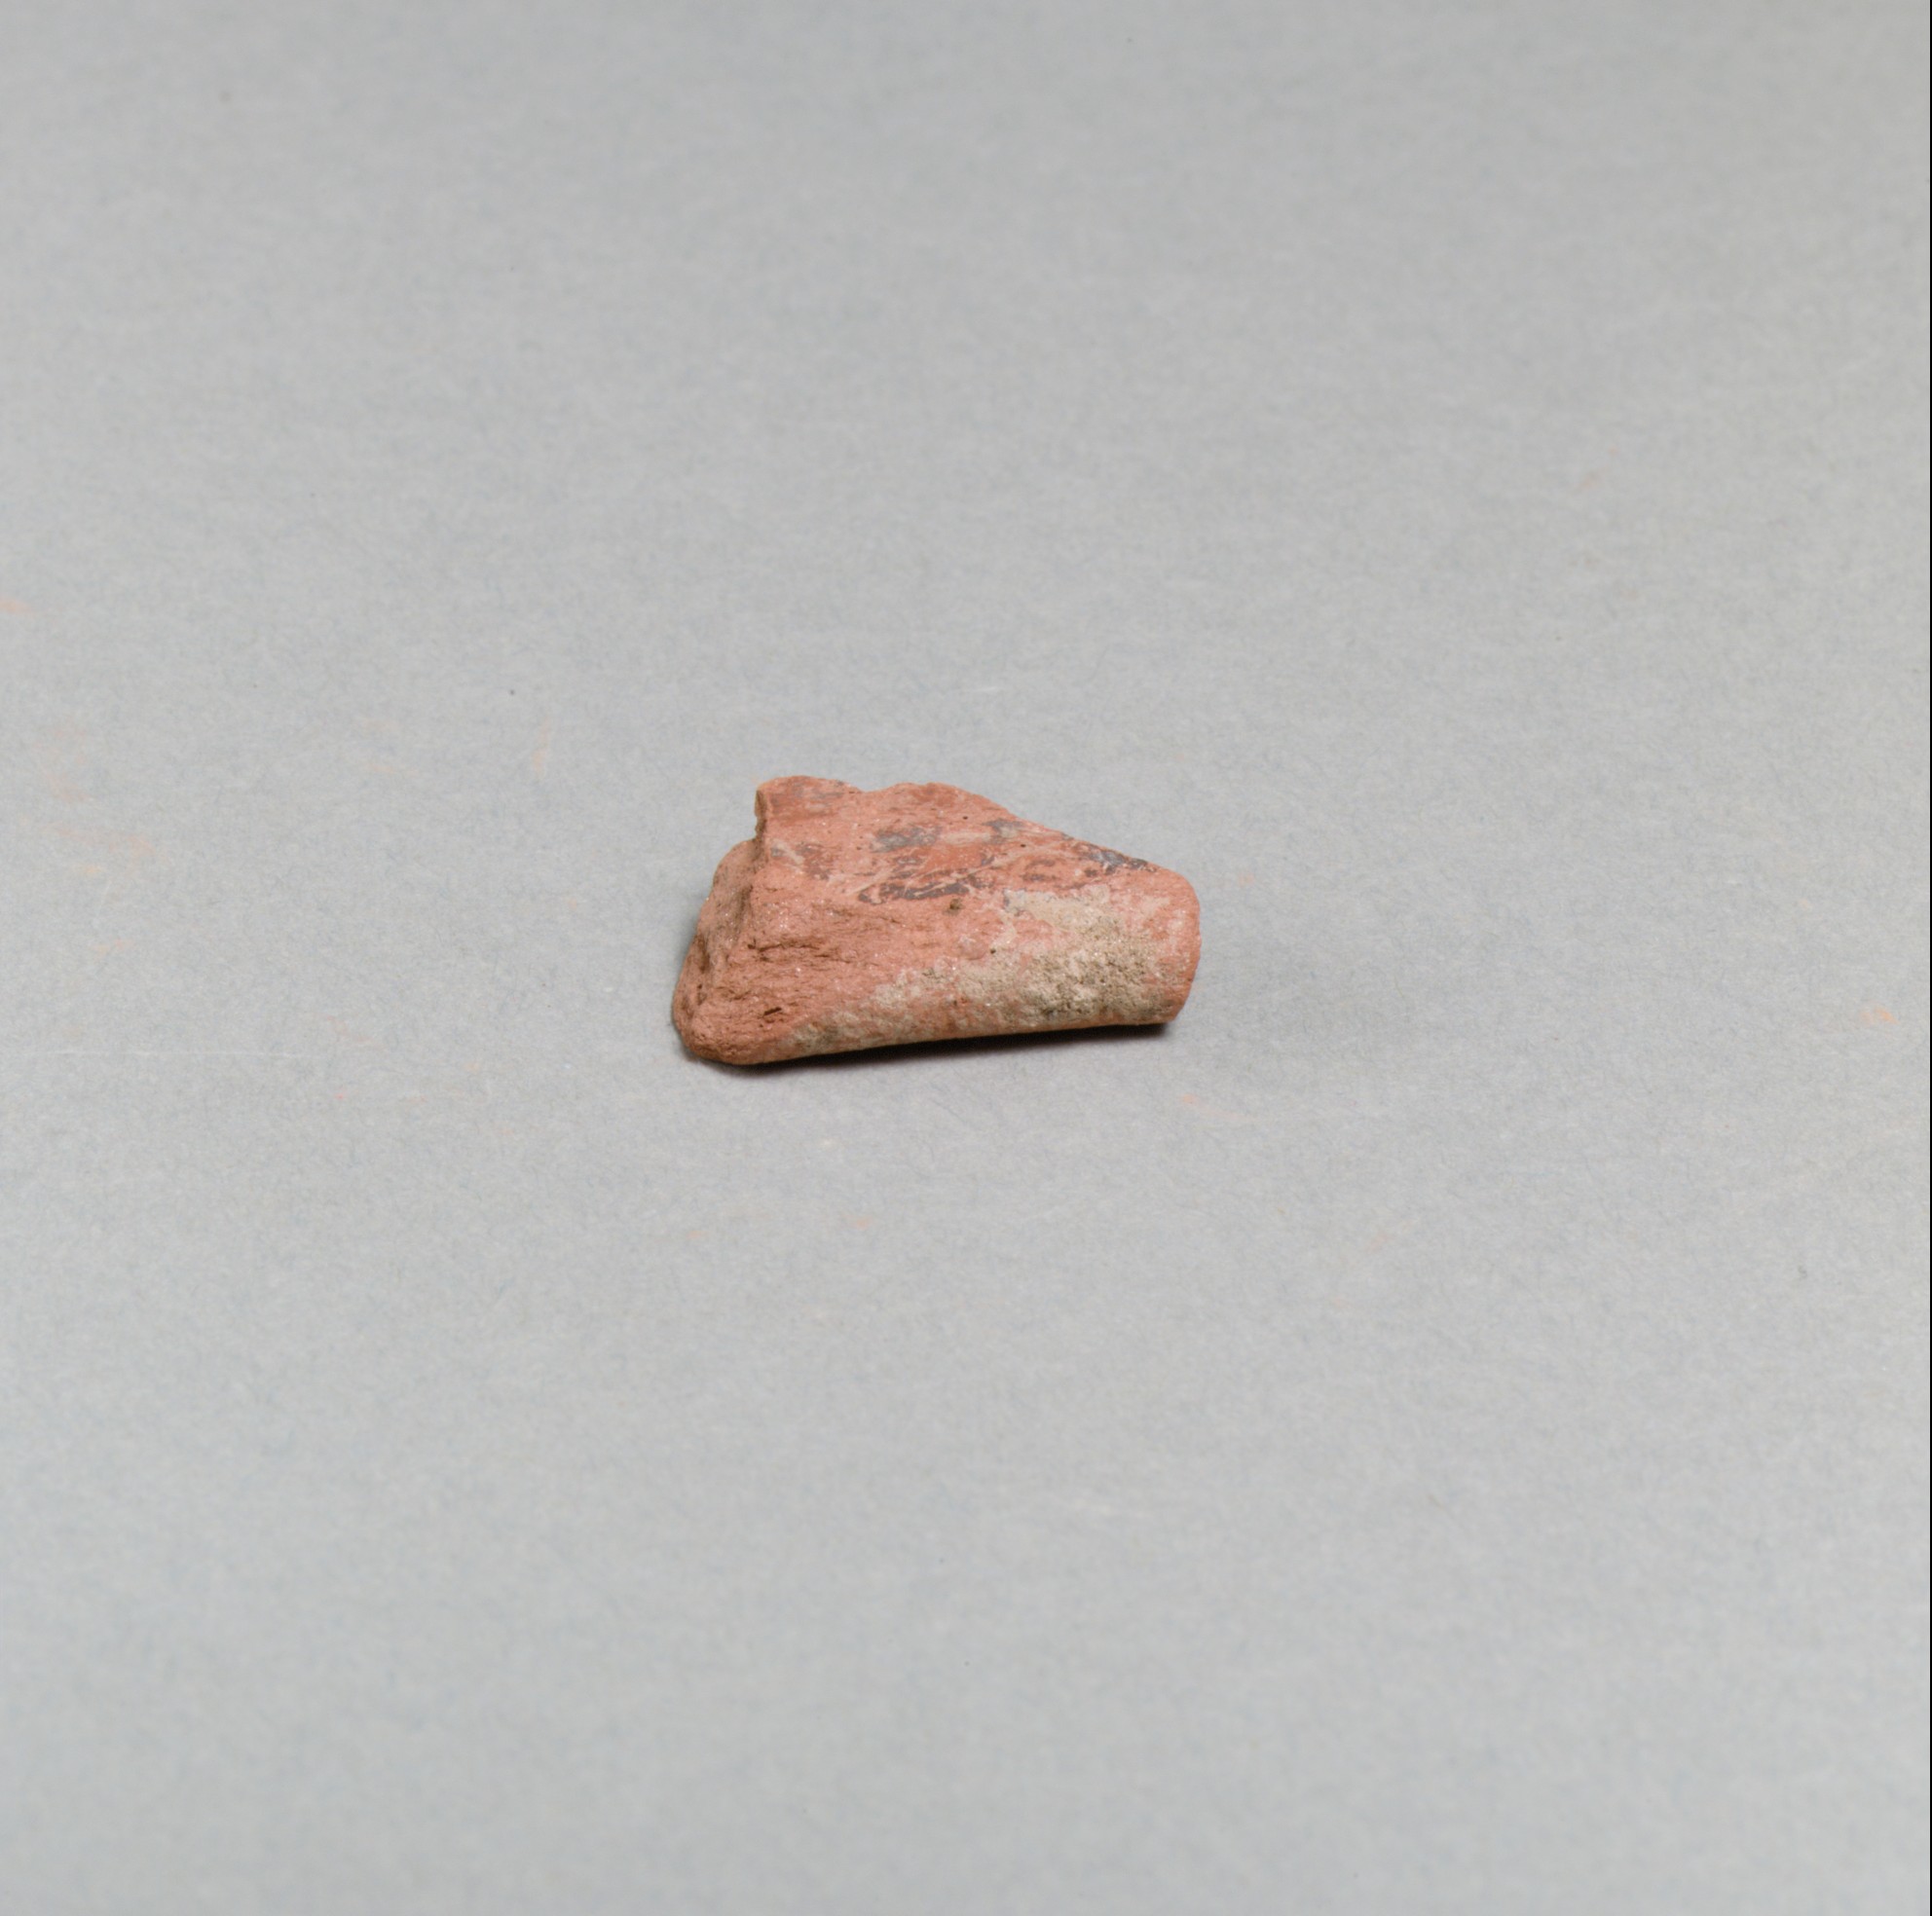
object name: vase fragment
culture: greek or lydian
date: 1050-700 BCE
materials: terracotta